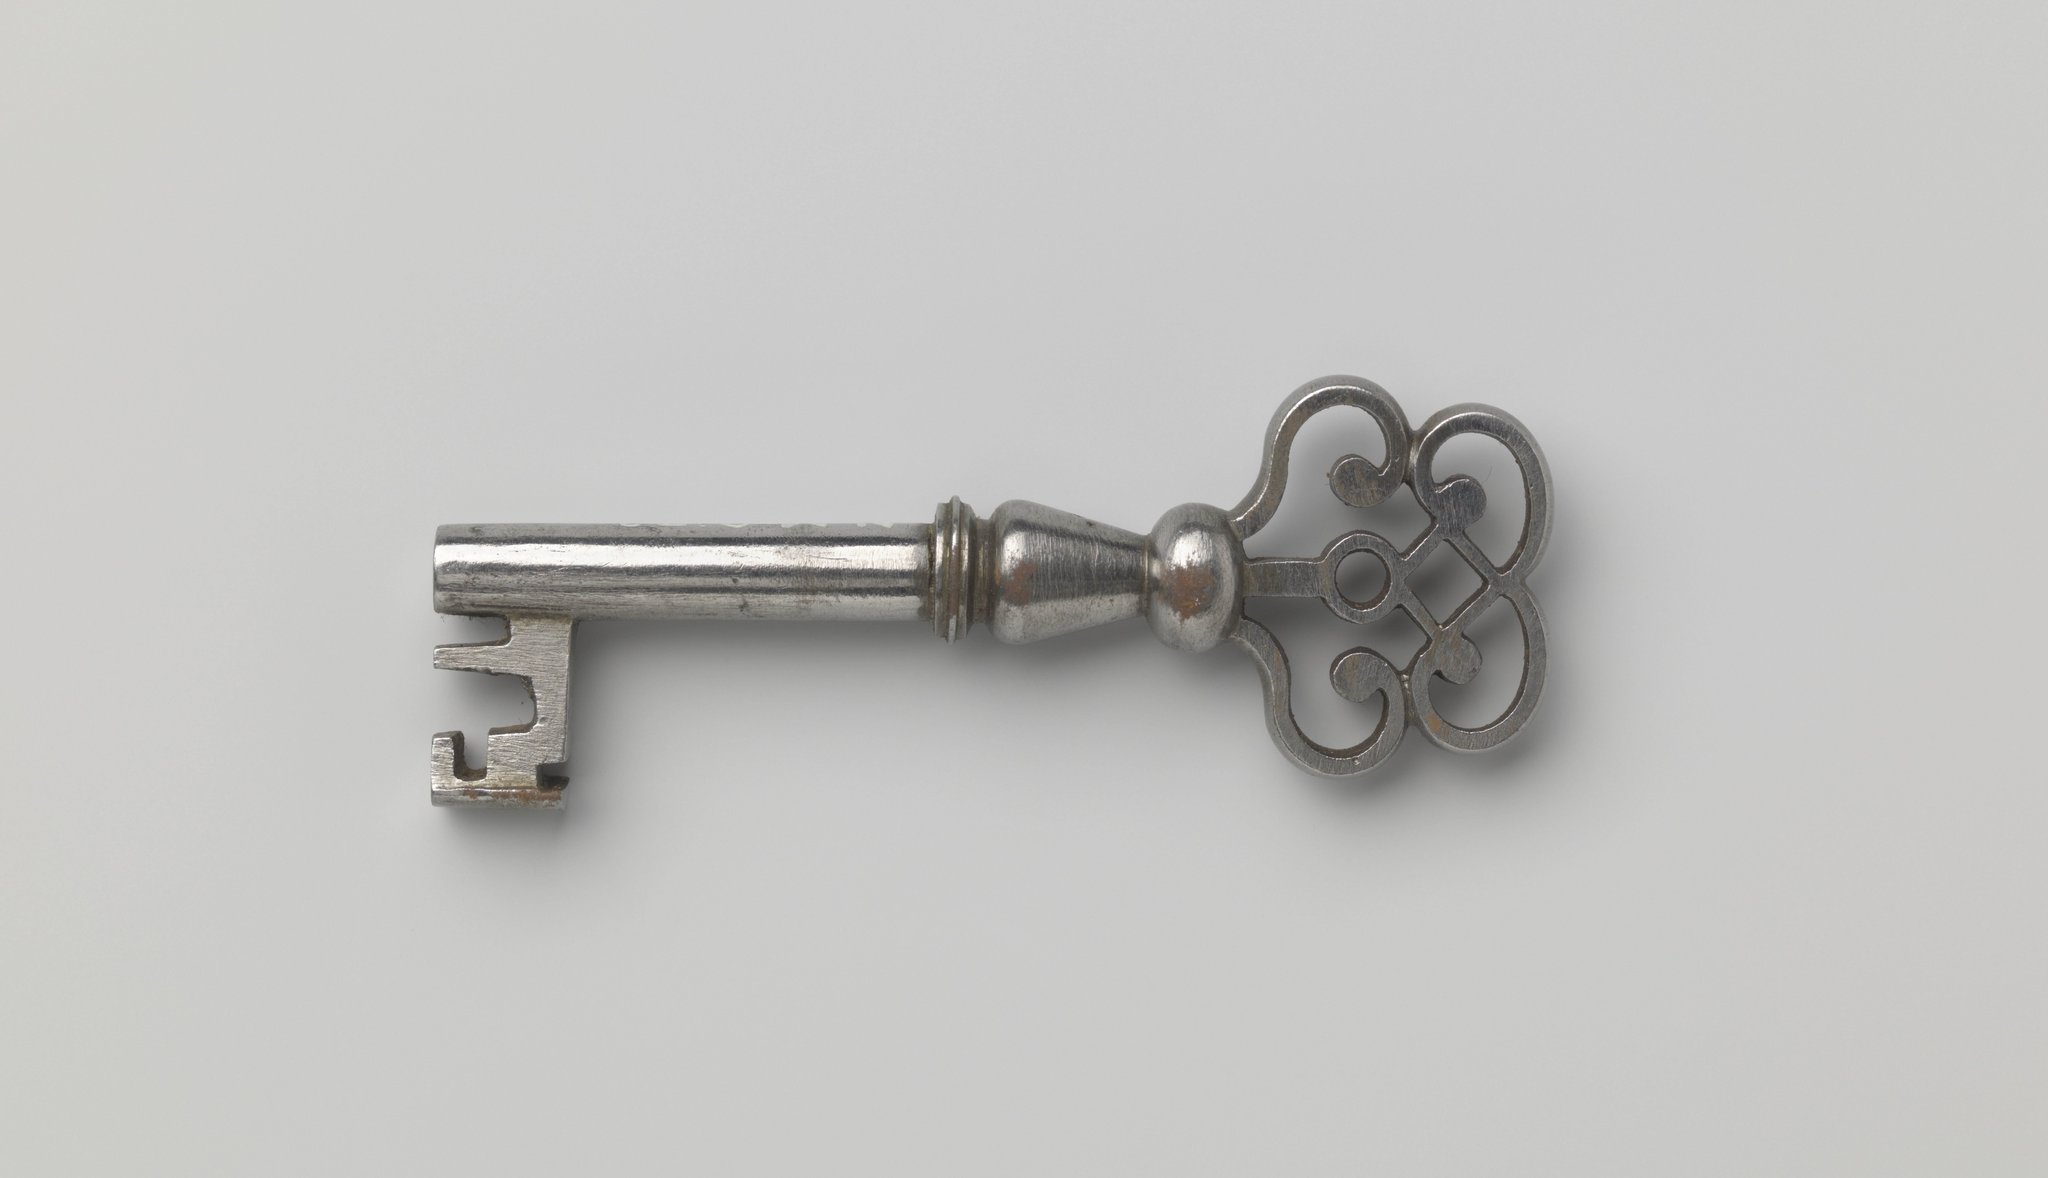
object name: key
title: Sleutel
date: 1400-1950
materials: iron